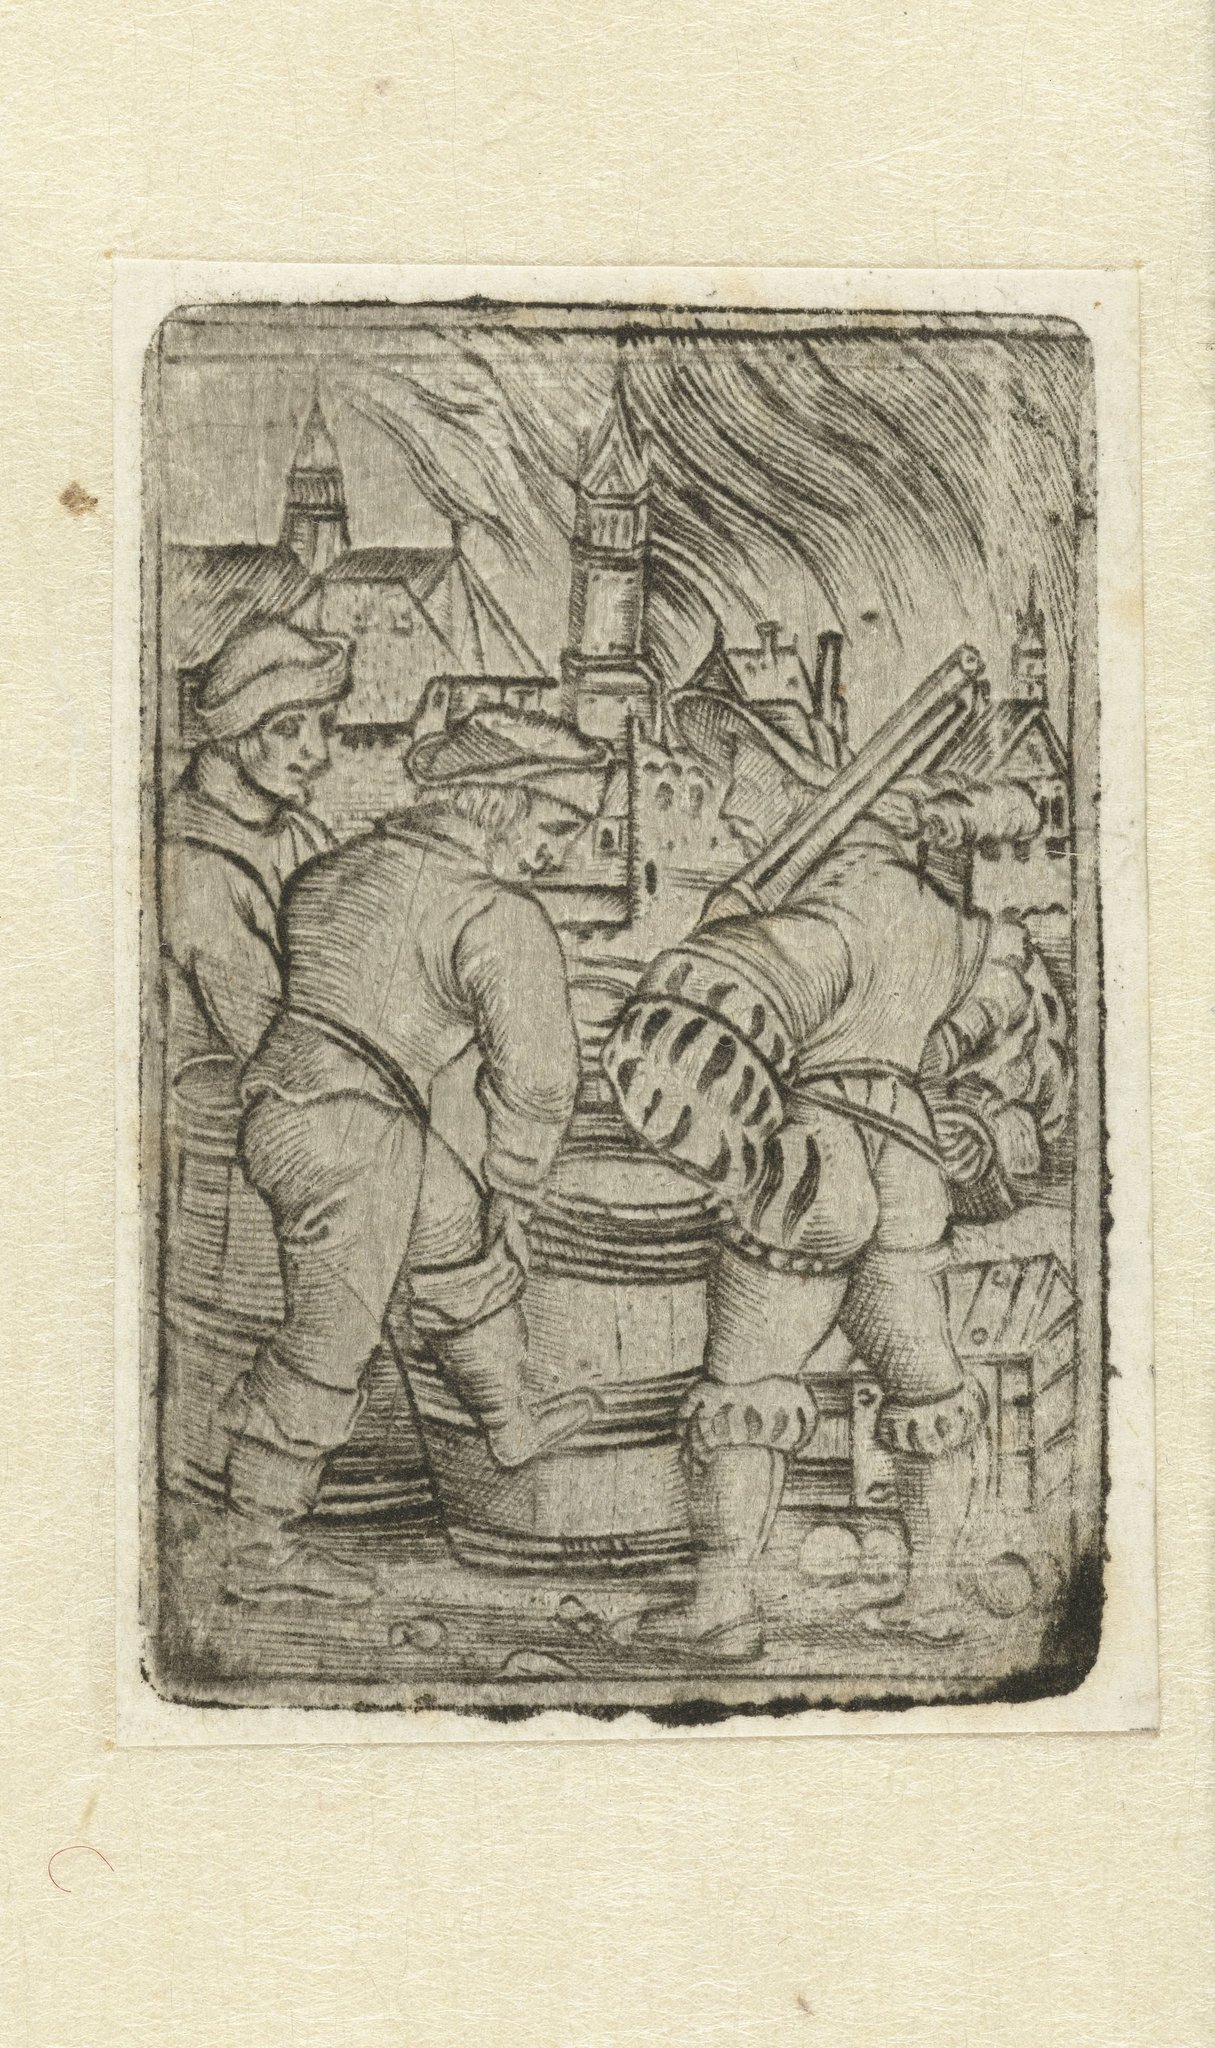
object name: print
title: Bewakers bij de kruitvaten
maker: Anonymous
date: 1510-1599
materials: paper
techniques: engraving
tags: projectiles, explosives, etc.: gunpowder, guarding of treasure by men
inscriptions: collector's mark: Lugt 240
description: Kopie in spiegelbeeld naar een prent van Hans Sebald Beham